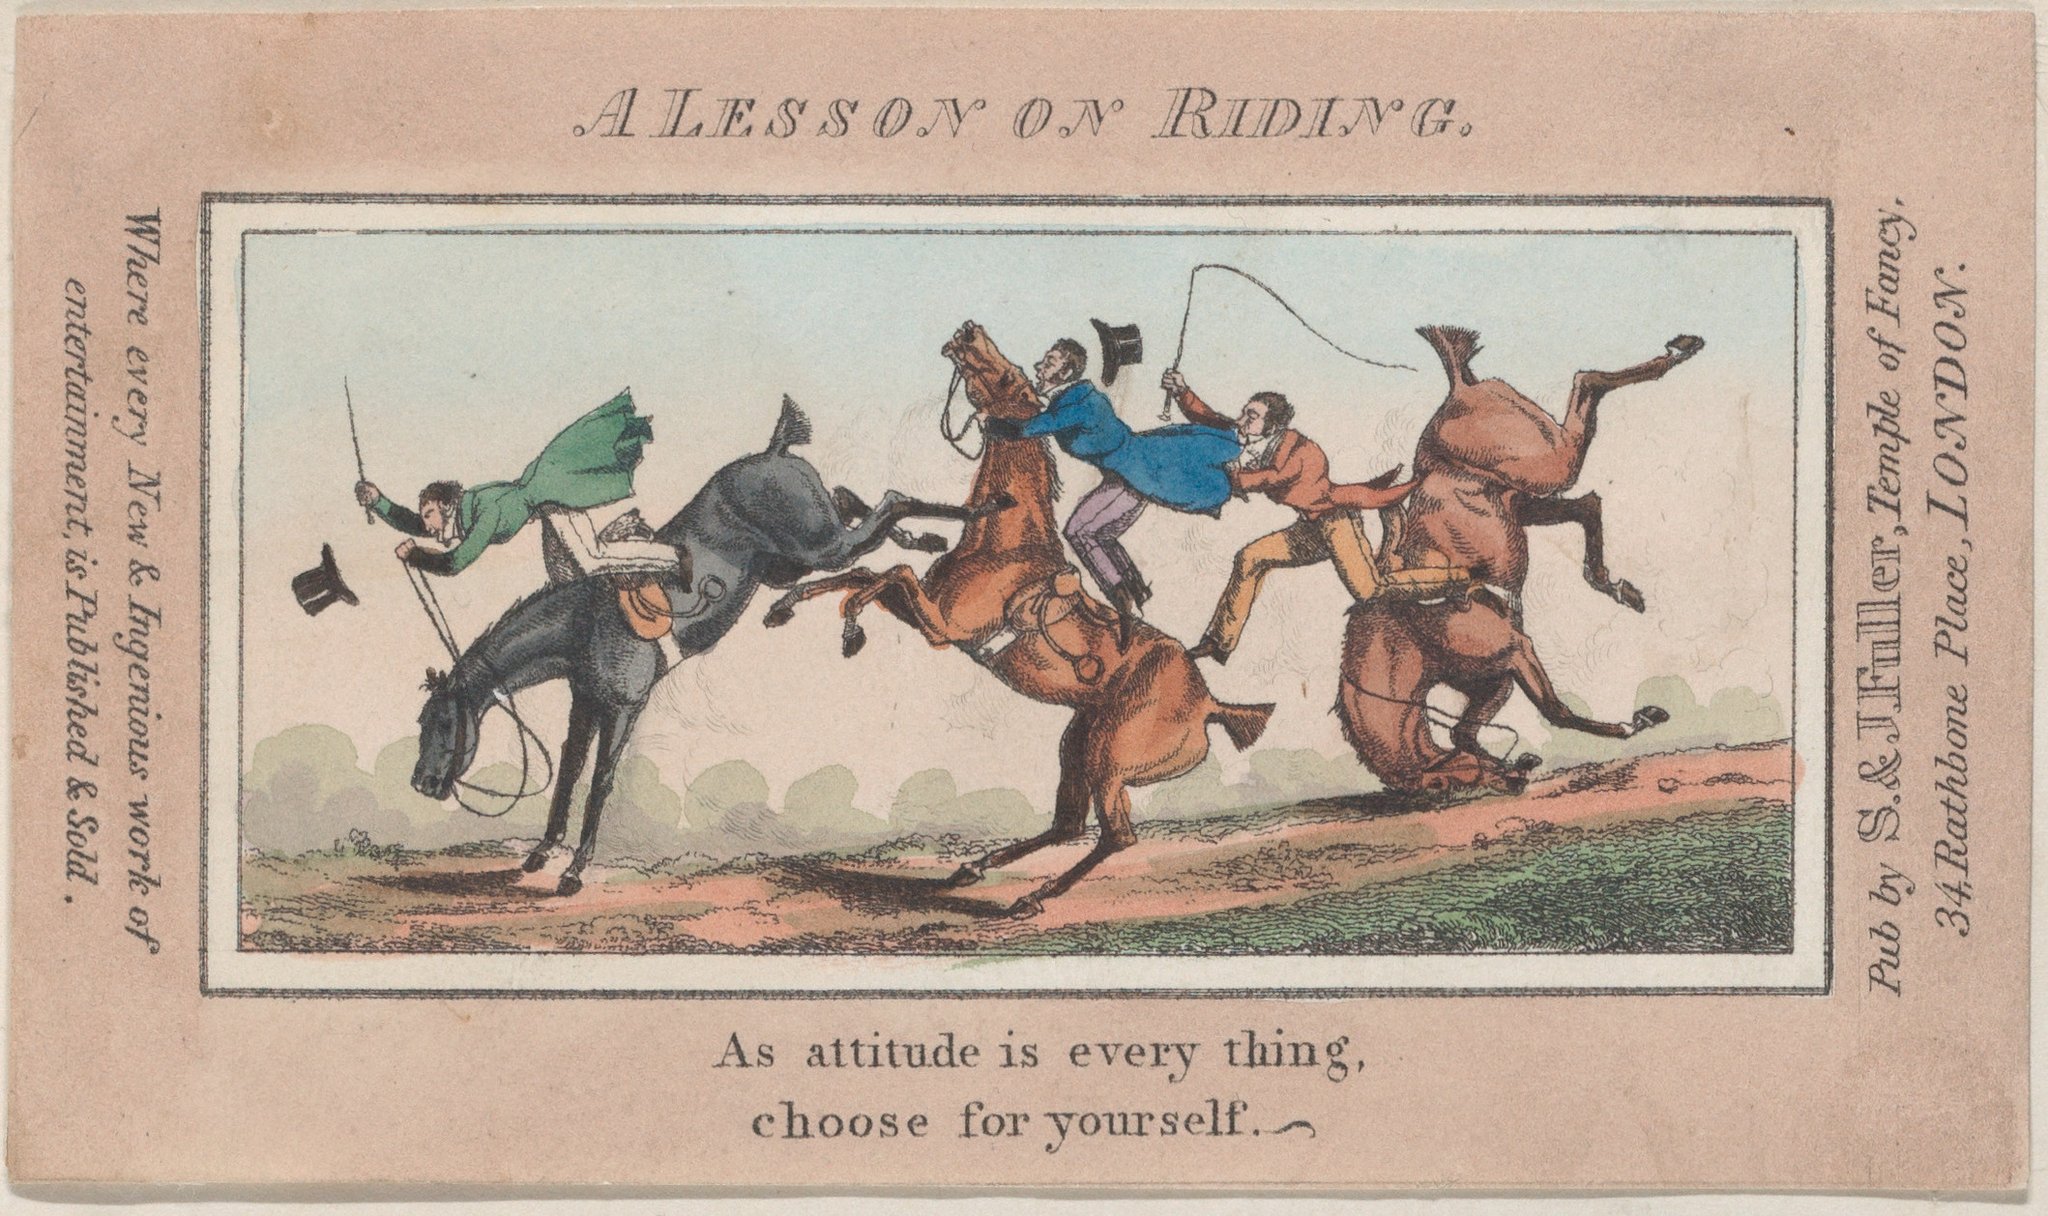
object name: print, trade card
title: Trade Card for S & J Fuller, Publisher and Printer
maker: anonymous, british, 19th century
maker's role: artist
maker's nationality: british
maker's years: 1800-1900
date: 1801-1900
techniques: engraving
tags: satire,men,horses